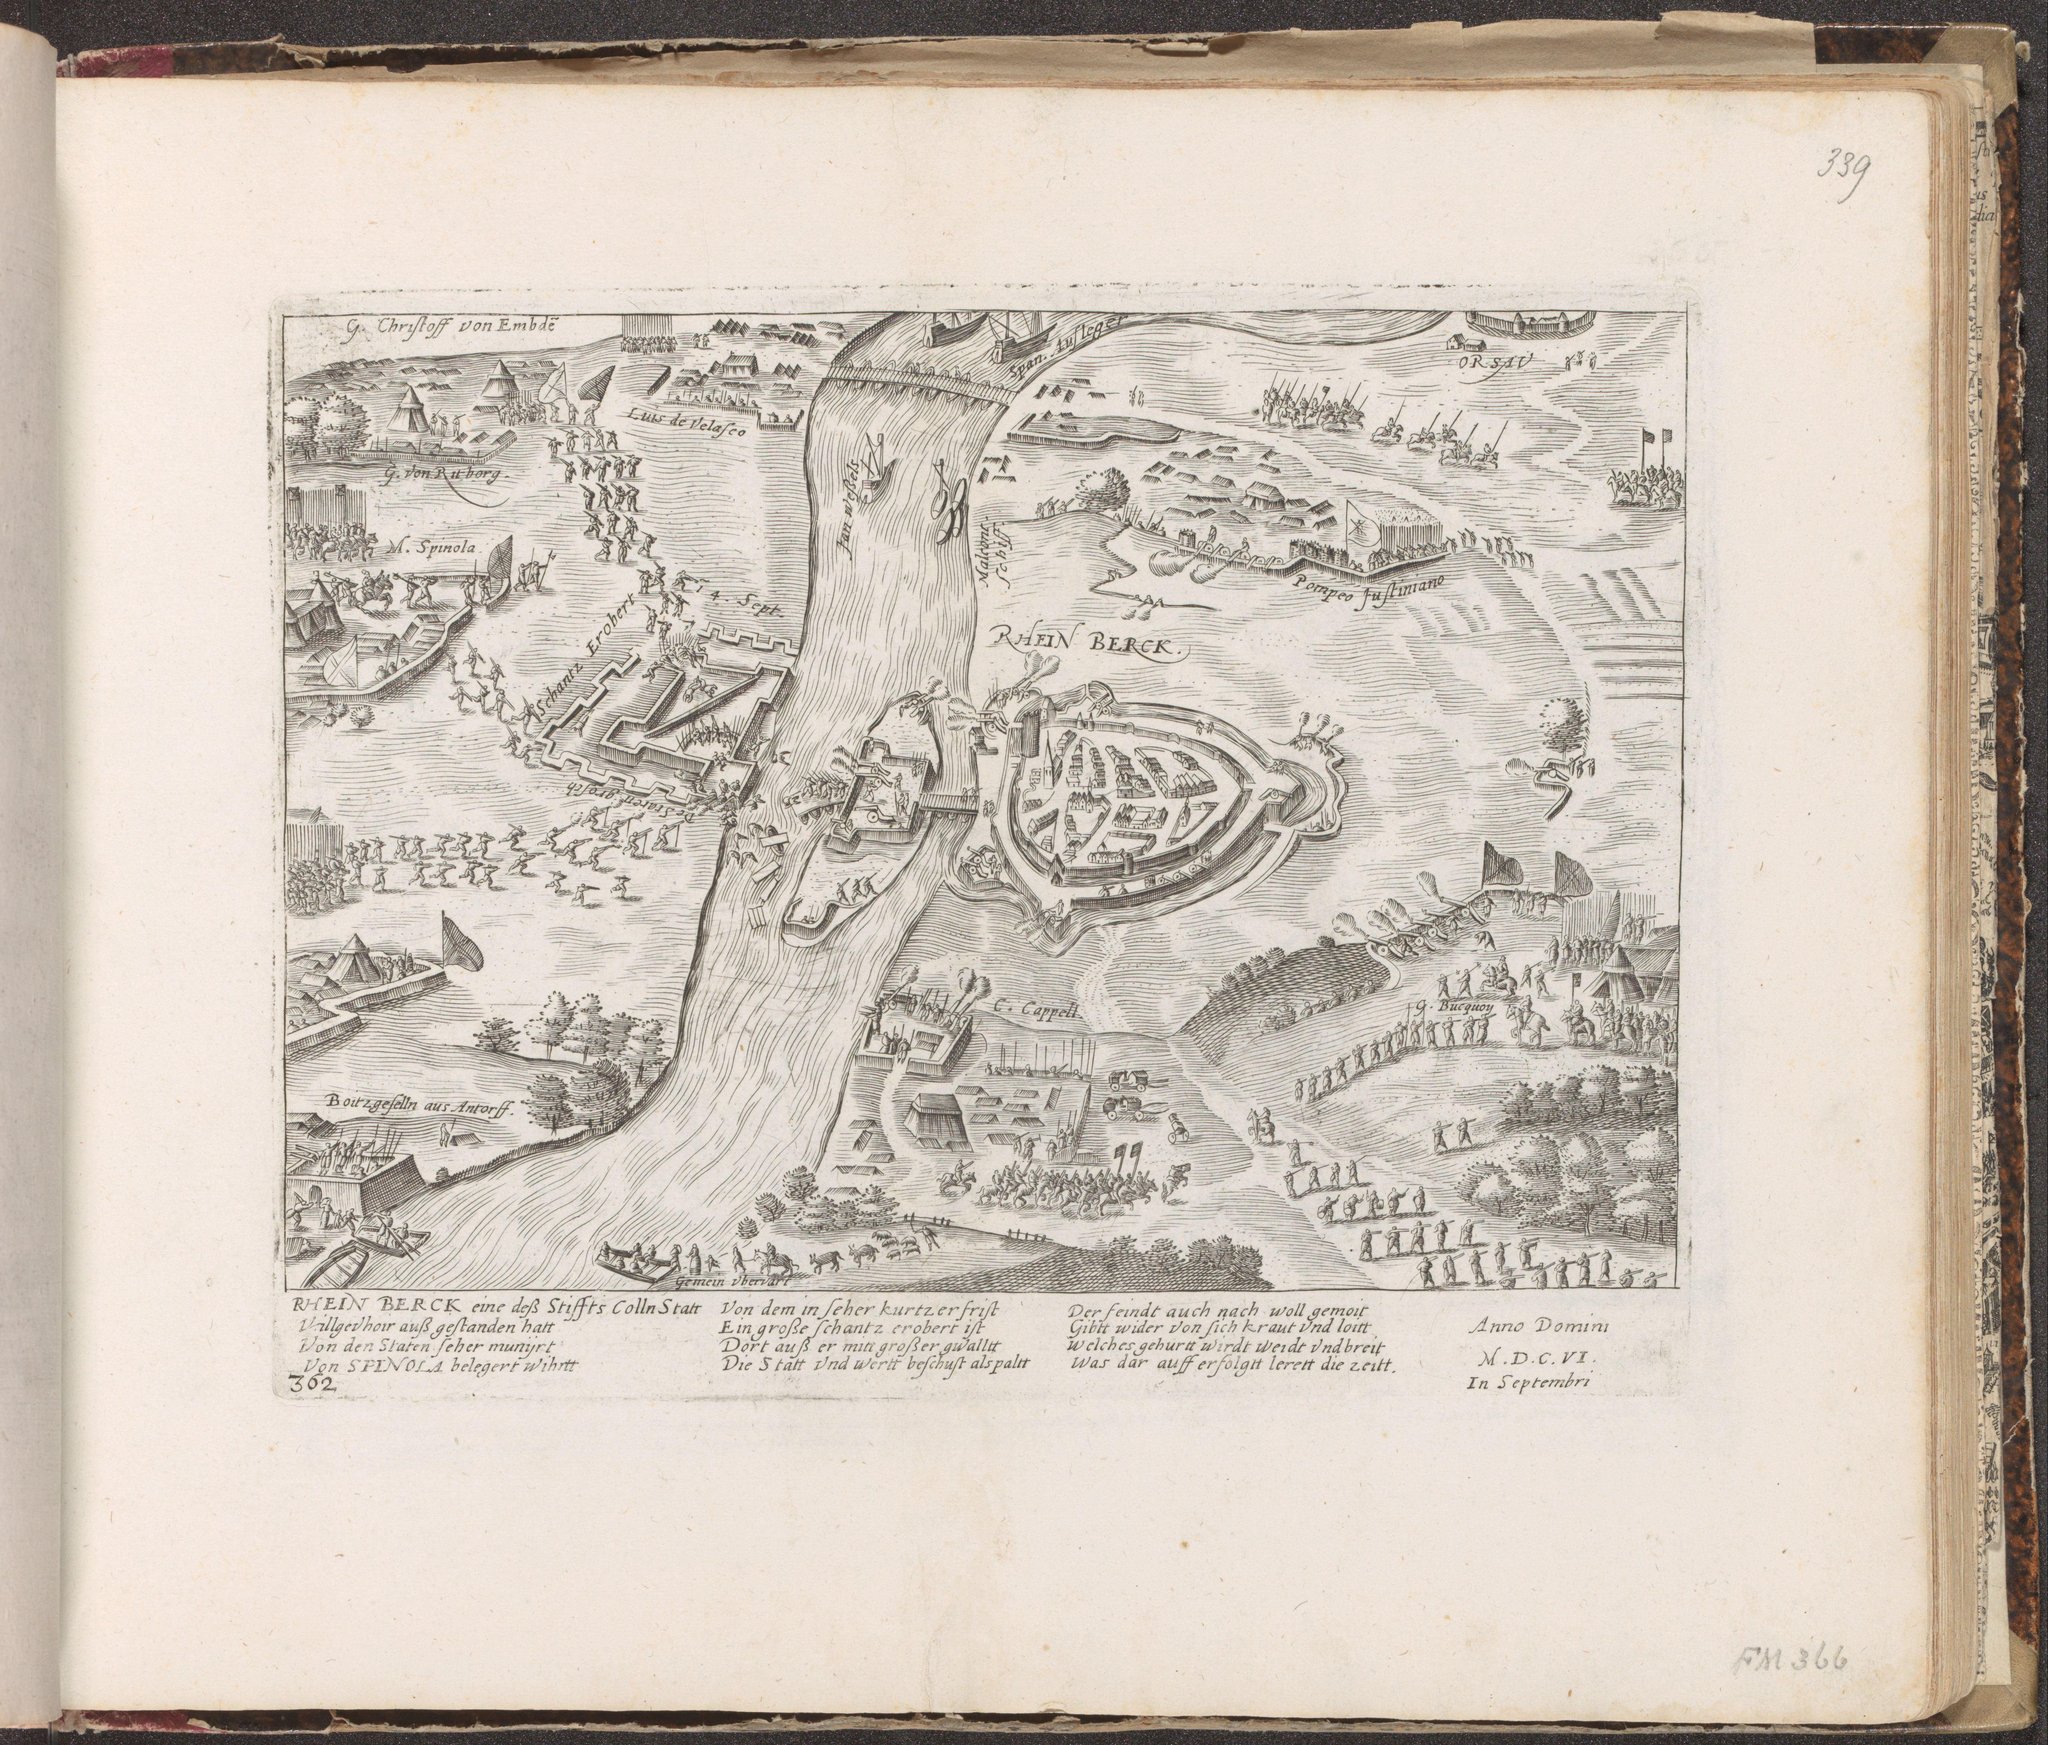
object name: print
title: Rheinberg belegerd door Spinola, 1606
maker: frans hogenberg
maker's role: print maker, publisher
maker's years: 1538-1590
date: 1606-1608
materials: paper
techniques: etching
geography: cologne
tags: siege, position war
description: Rheinberg belegerd door het leger van Spinola, september 1606. Overzicht van de omgeving van Rheinberg met de legerplaatsen van de verschillende legeronderdelen van Spinola. Met onderschrift van 12 regels in het Duits. Linksonder genummerd: 362. De prent maakt deel uit van een album.